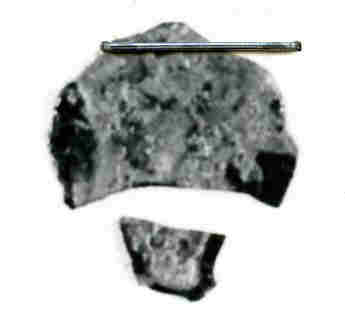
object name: coin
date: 401-1400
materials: copper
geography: iran